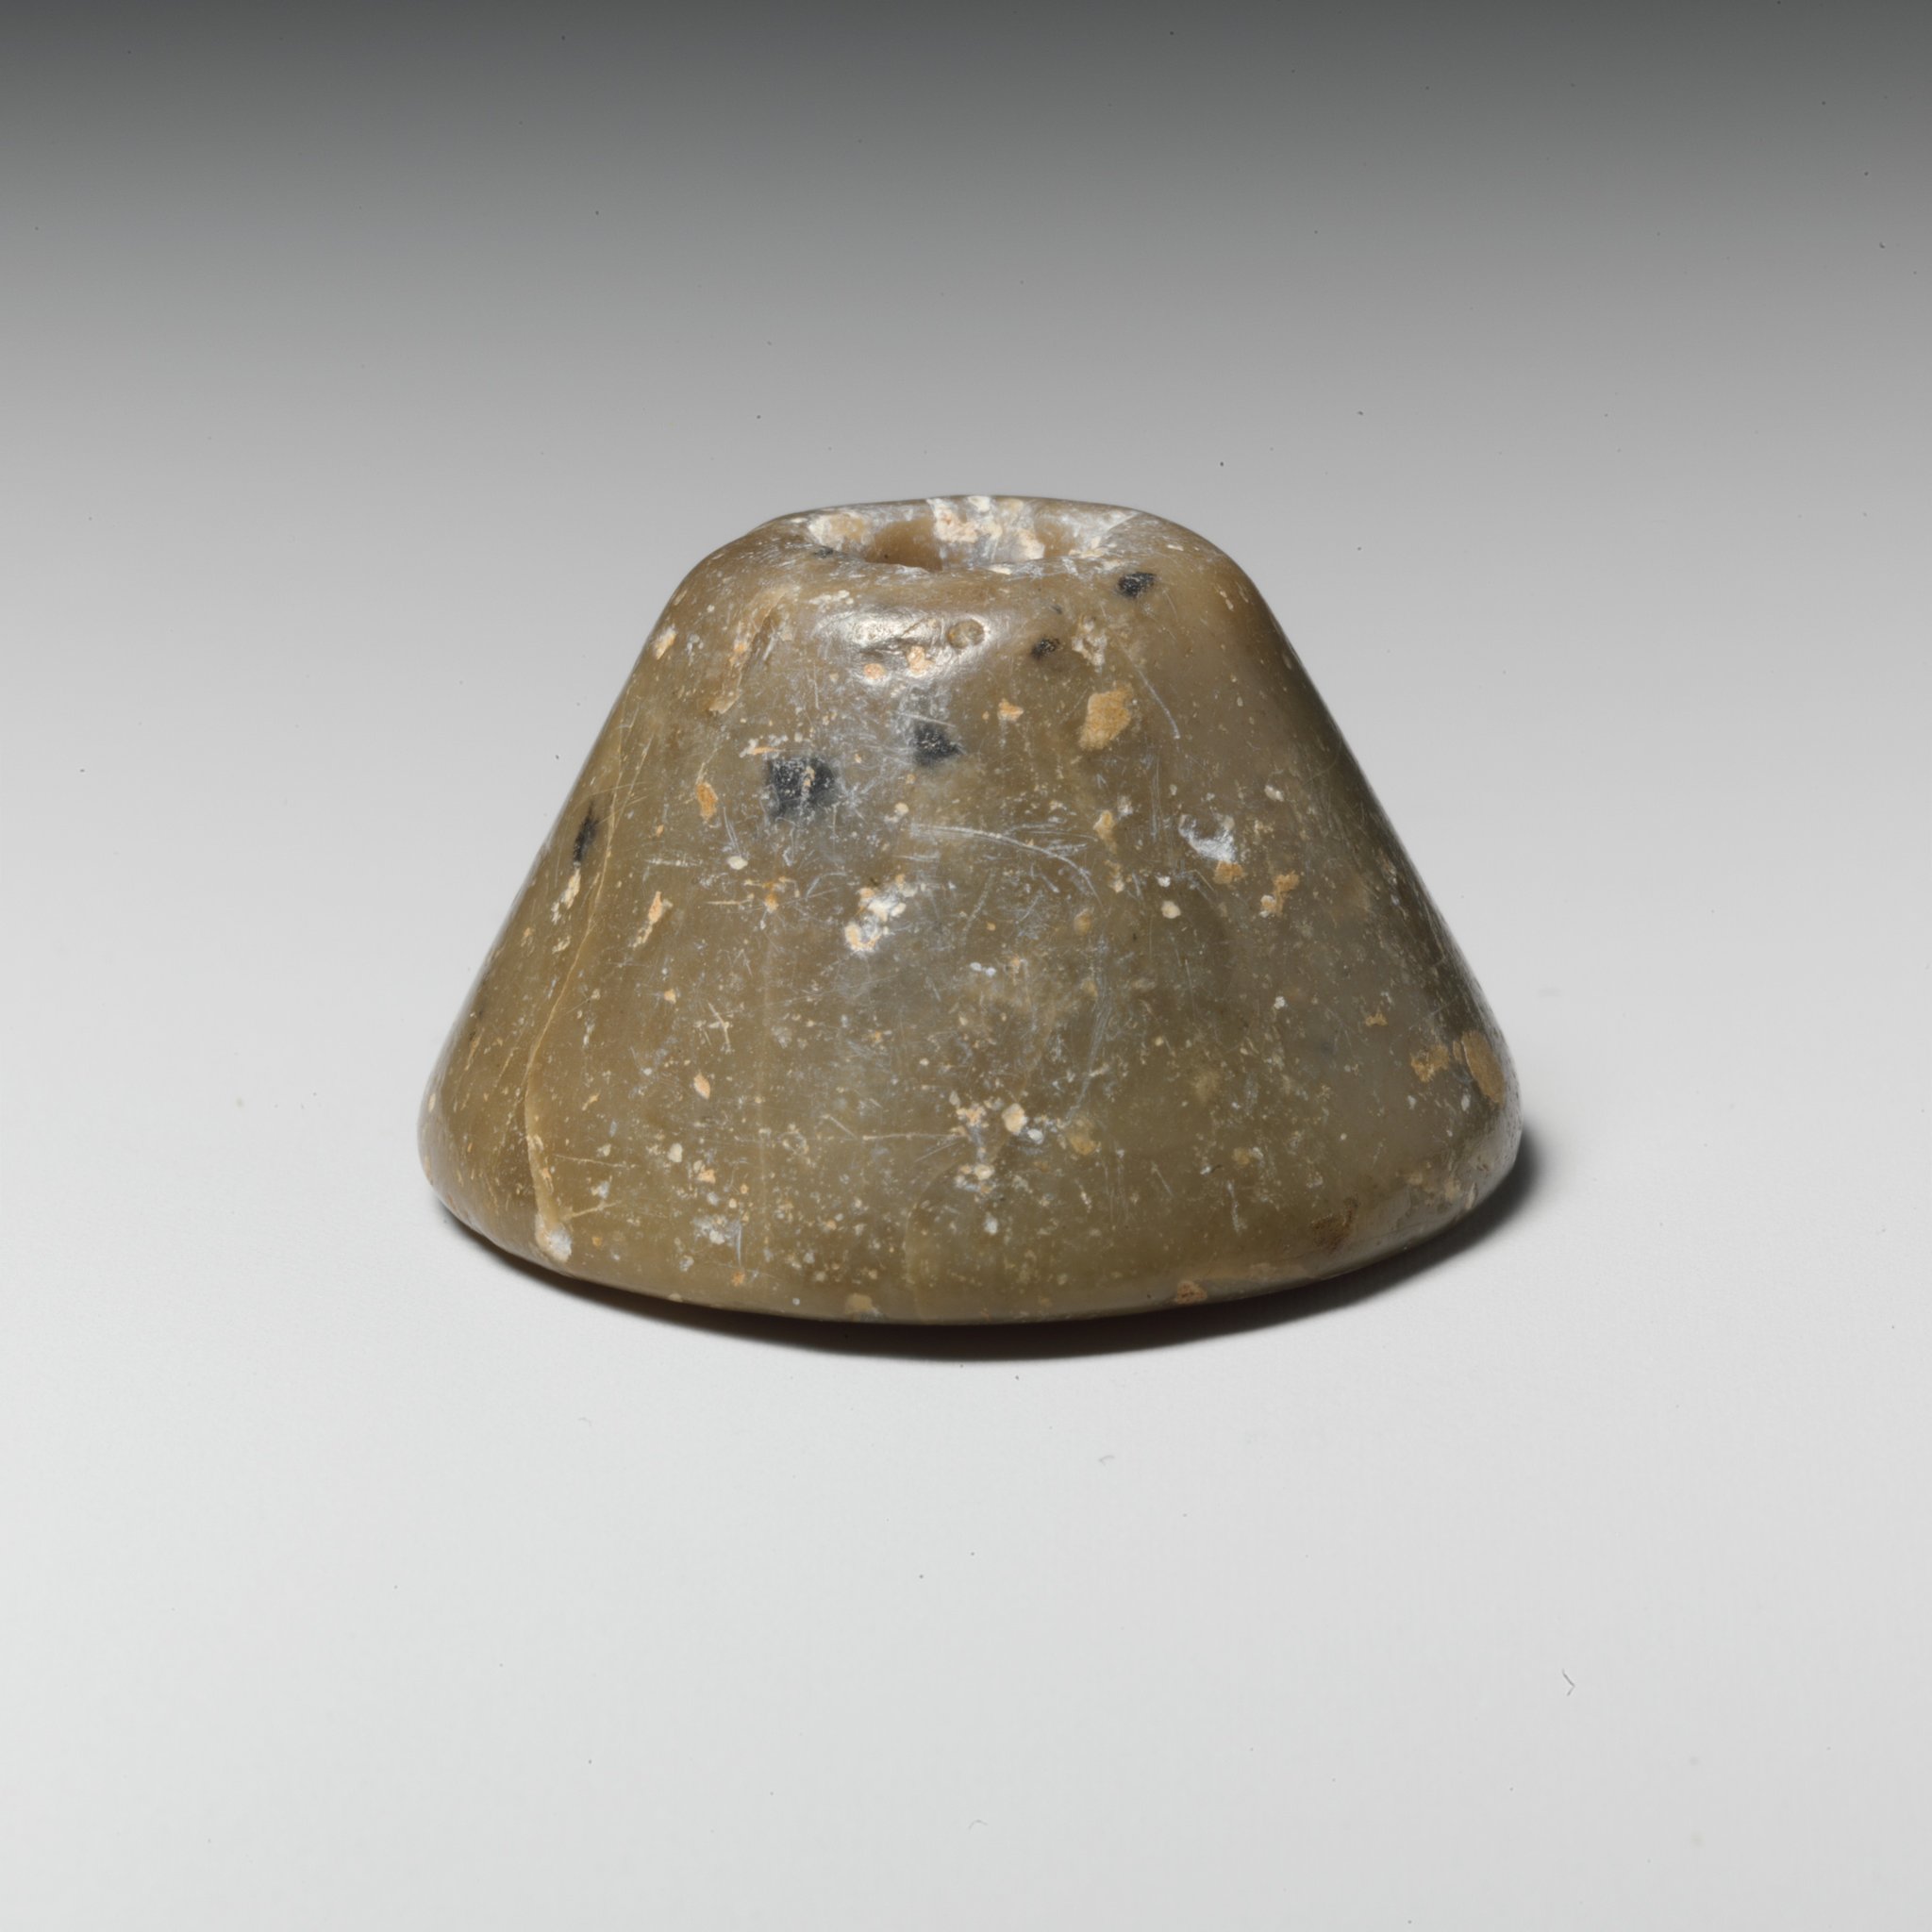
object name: spindle whorl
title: Stone spindle whorl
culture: minoan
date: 2400-1900 BCE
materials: stone